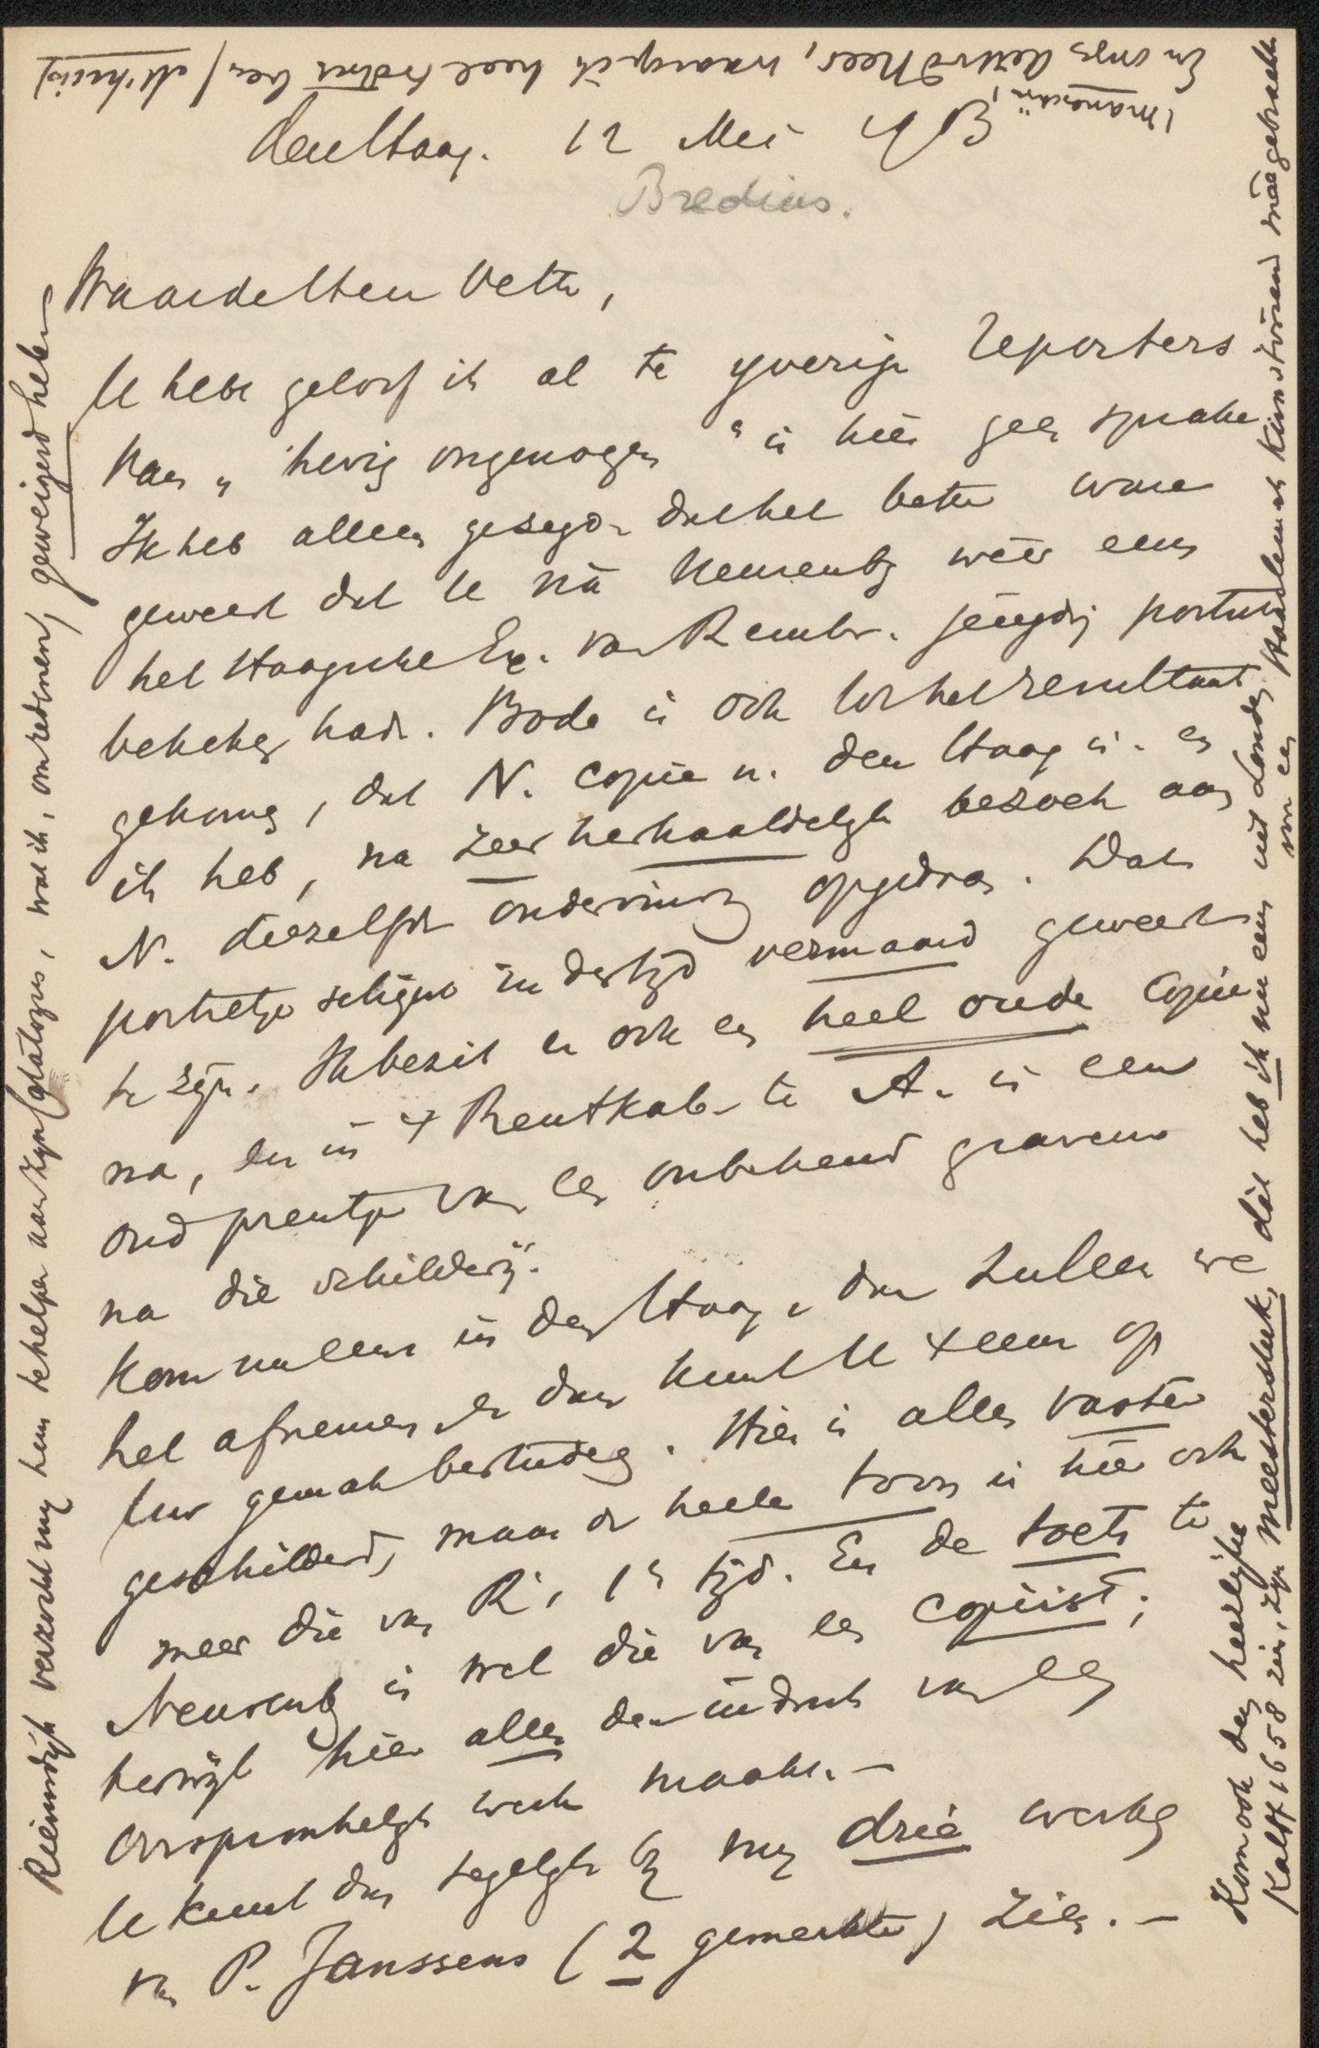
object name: letter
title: Brief aan Jan Veth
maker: abraham bredius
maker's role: kunsthistoricus, museumdirecteur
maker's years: 1855-1946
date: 1903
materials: ink, paper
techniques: pen, writing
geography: the hague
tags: dordrecht, painter, print maker, draughtsman, designer, jan veth, berlin, wilhelm von bode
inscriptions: collector's mark: ‘RPK’